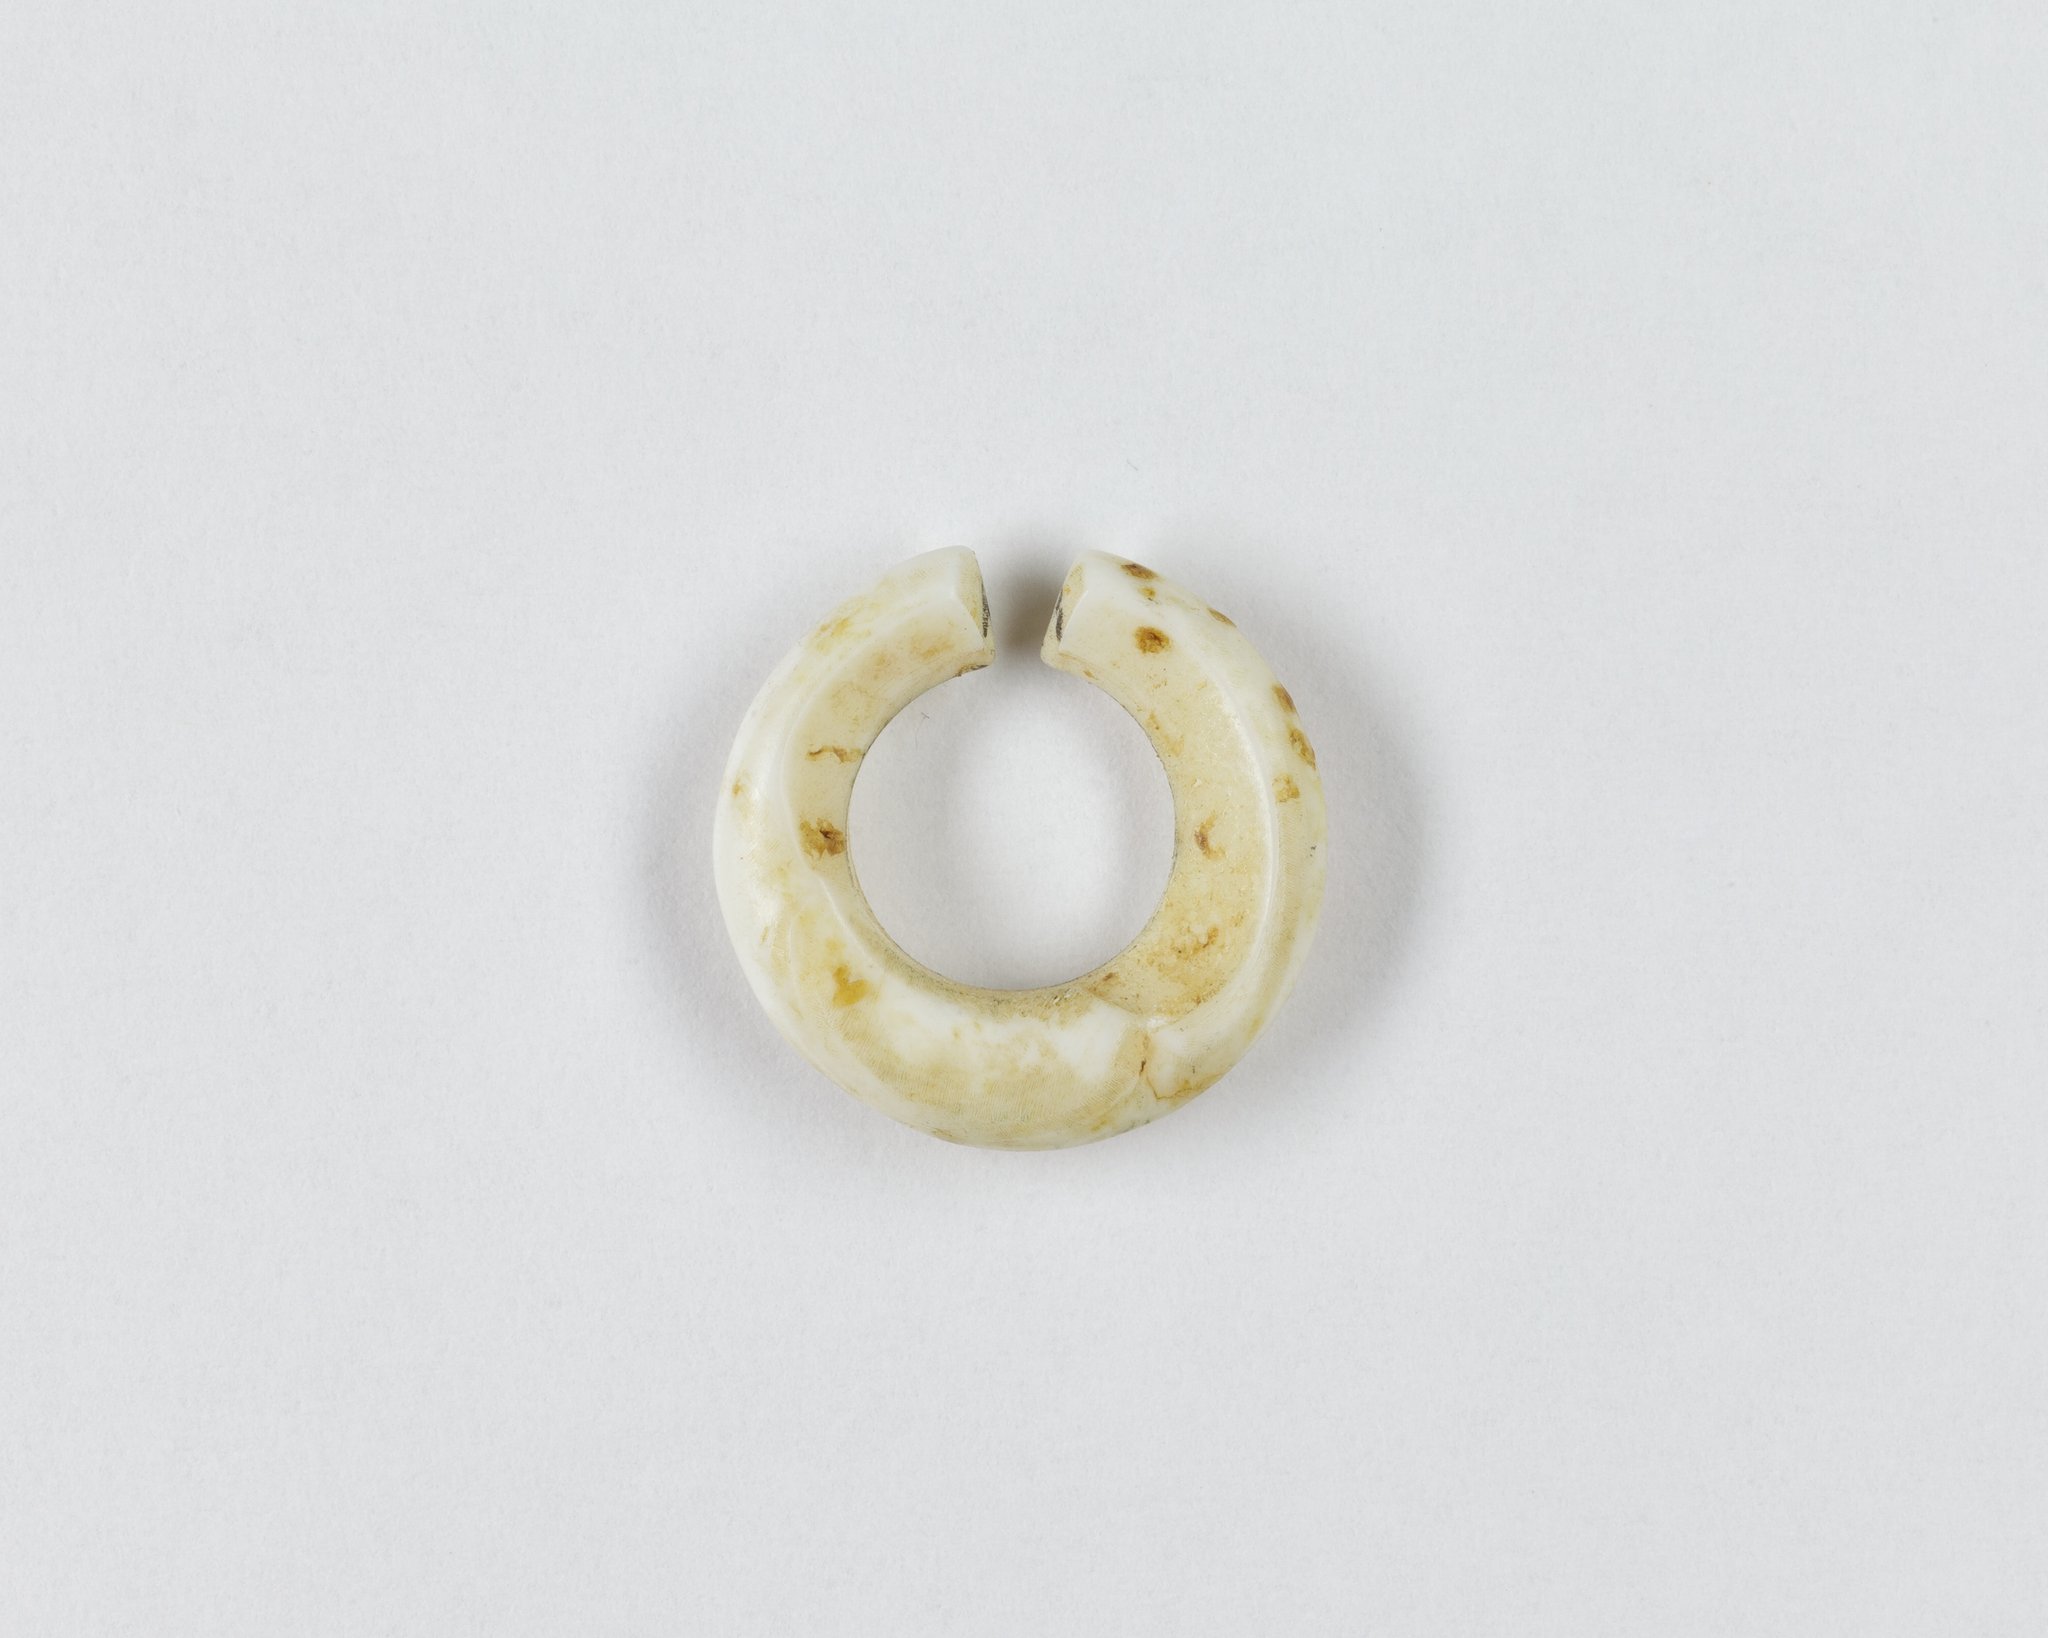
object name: earring, penannular, circular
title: Penannular Earring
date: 1550-1295 BCE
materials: shell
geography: northern upper egypt